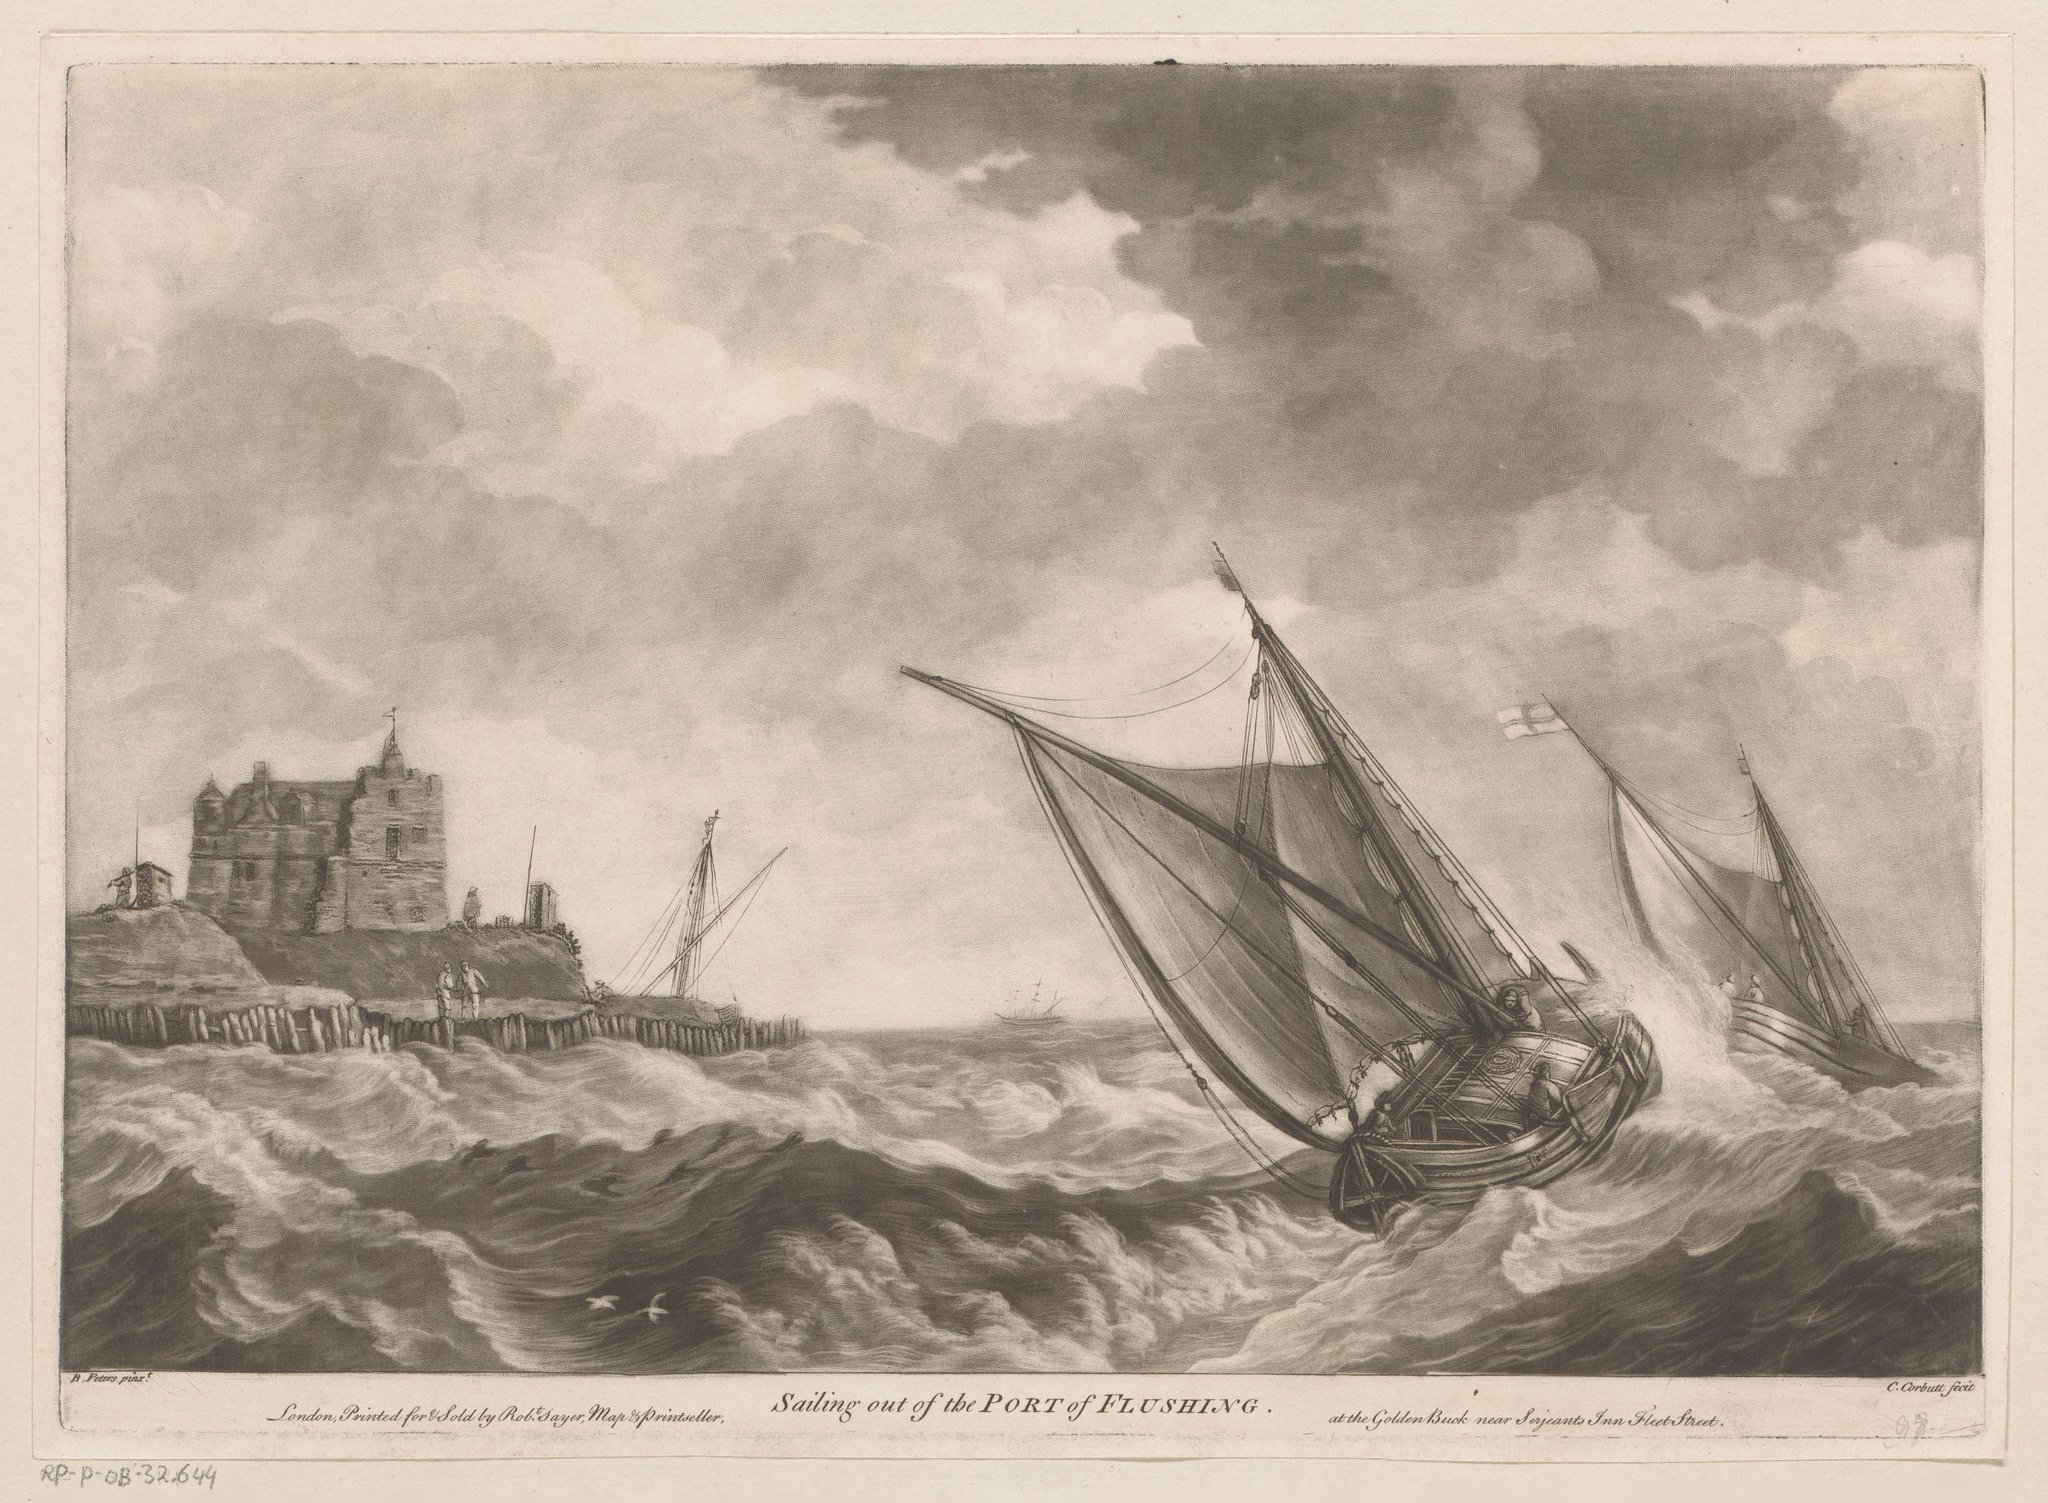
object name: print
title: Sailing out of the Port of Flushing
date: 1746-1794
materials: paper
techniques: etching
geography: london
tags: harbour, sailing-ship, sailing-boat, departure ~ travelling, flushing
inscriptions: collector's mark: Lugt 240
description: Prent maakt mogelijk deel uit van een serie.